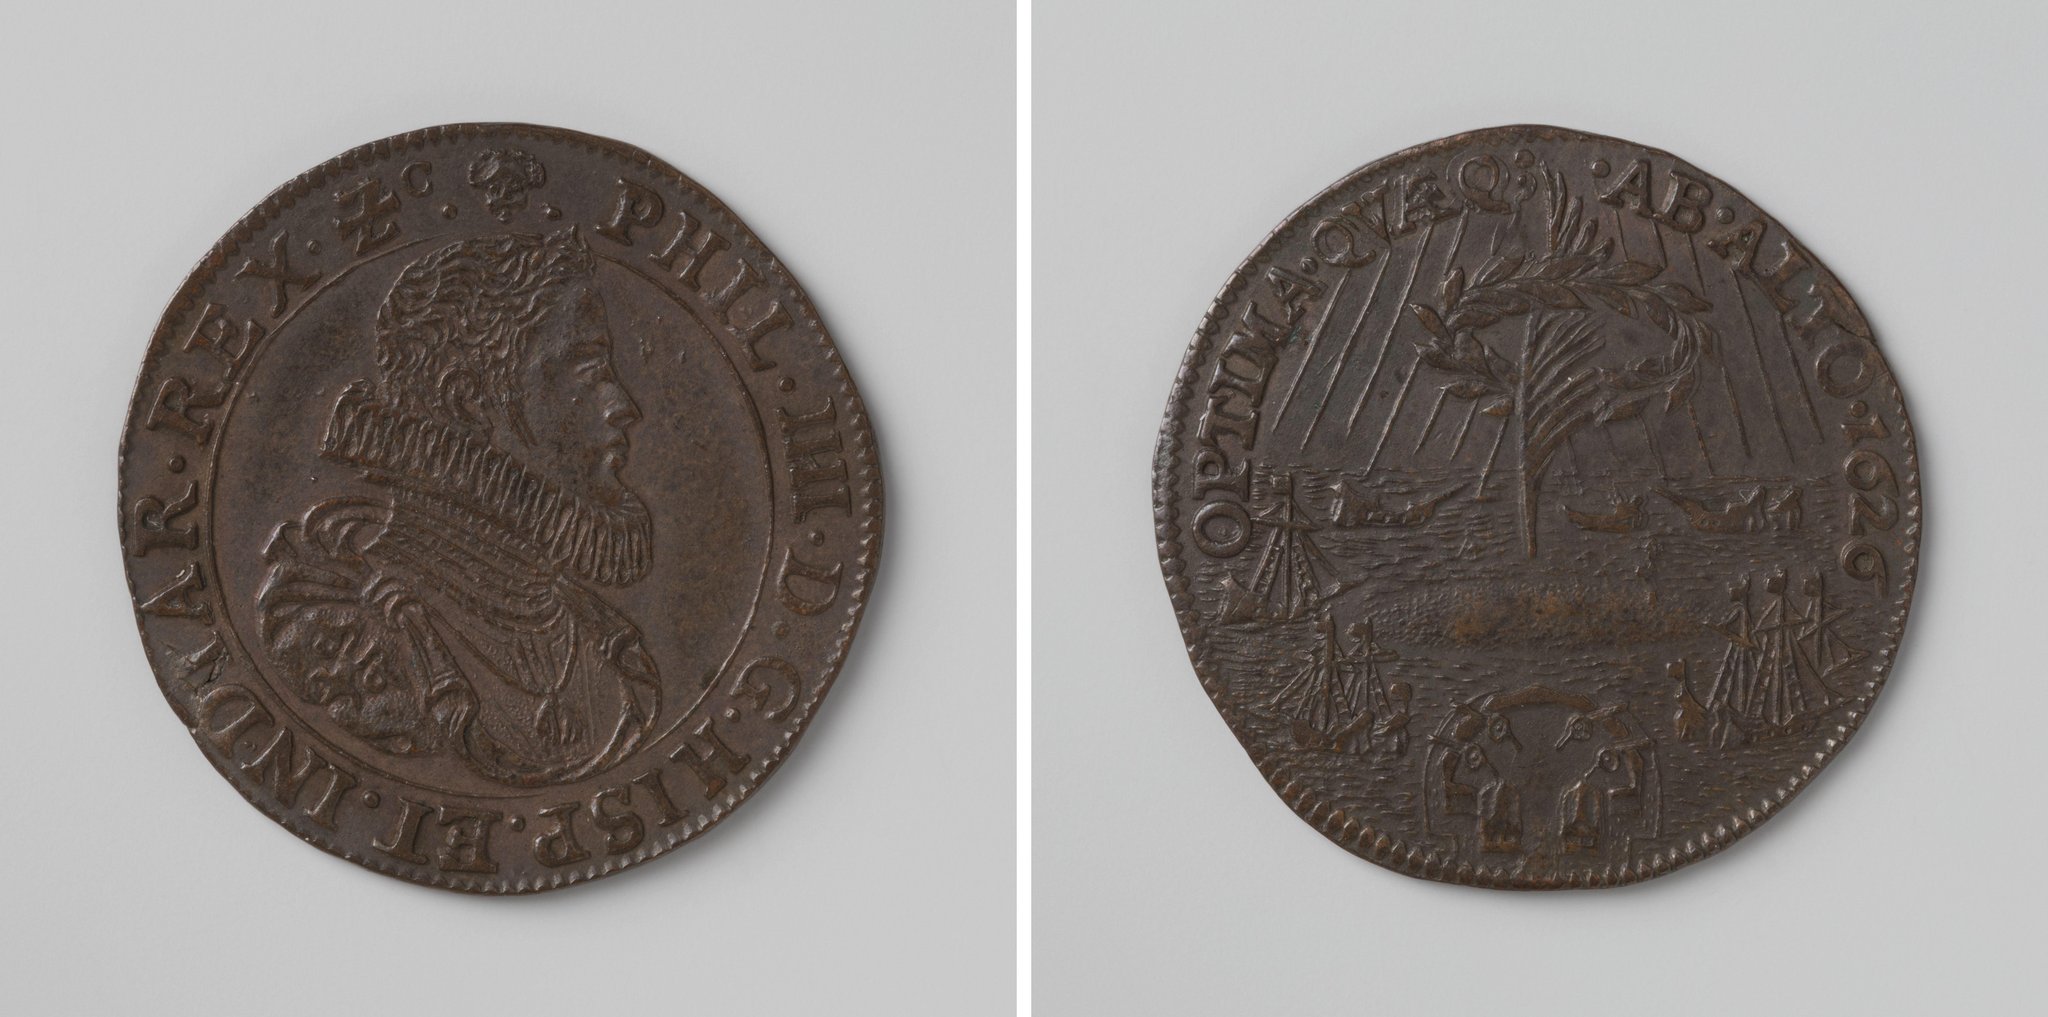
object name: jeton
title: Mislukte aanslag van Frederik Hendrik, prins van Oranje-Nassau, op Hulst, rekenpenning geslagen ter ere van Filips IV, koning van Spanje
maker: Anonymous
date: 1626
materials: copper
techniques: striking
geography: brussels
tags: the hague, frederick henry (prince of orange), filips iv (koning van spanje)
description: Koperen penning. Voorzijde: borststuk man binnen omschrift. Keerzijde: vier schepen, vastgelopen op zandbank bij havenhoofd van Kieldrecht; op achtergrond palmtak, omhangen met lauwerkrans binnen omschrift